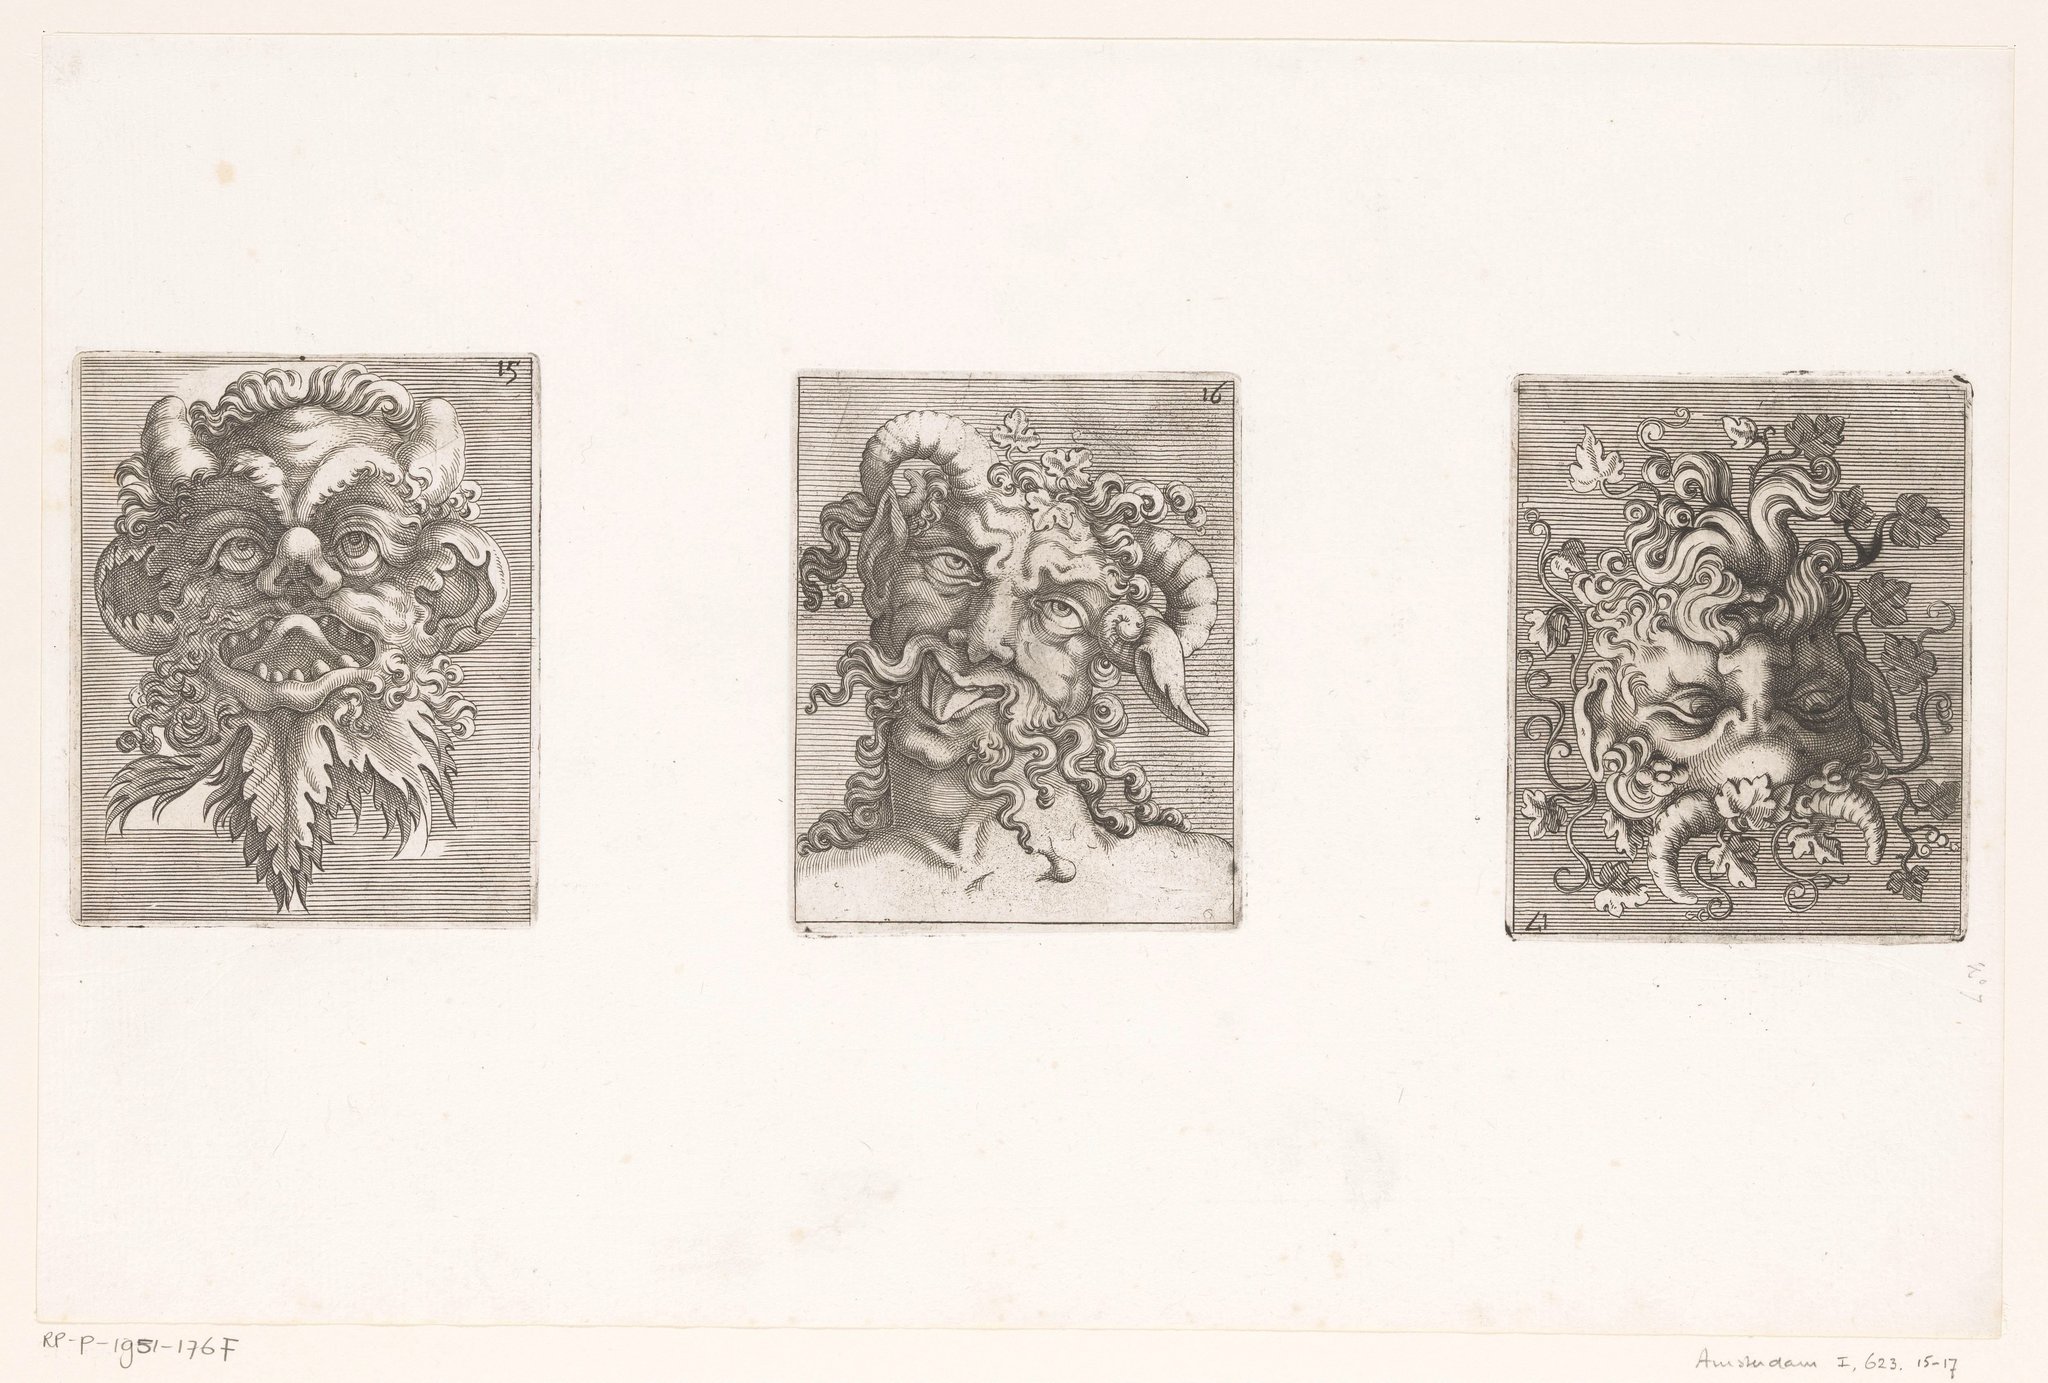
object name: ornament print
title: Drie groteske maskers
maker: adamo scultori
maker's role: painter, print maker, sculptor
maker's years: 1530-1585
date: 1540-1585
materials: paper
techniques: etching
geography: italy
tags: mask, mask, mascaron ~ ornament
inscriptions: collector's mark: Lugt 2228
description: Deze prenten maken deel uit van een reeks van 38 genummerde prenten van maskers. Het begint met twintig voorstellingen van groteske maskers en één ongenummerde ronde prent met het hoofd van Silenus. Daar op volgen 18 voorstellingen van antieke maskers. Op basis van de doornummering kunnen ook de laatste 18 prenten worden toegeschreven aan Adamo Scultori. Telkens zijn er drie platen op één blad bij elkaar gedrukt.